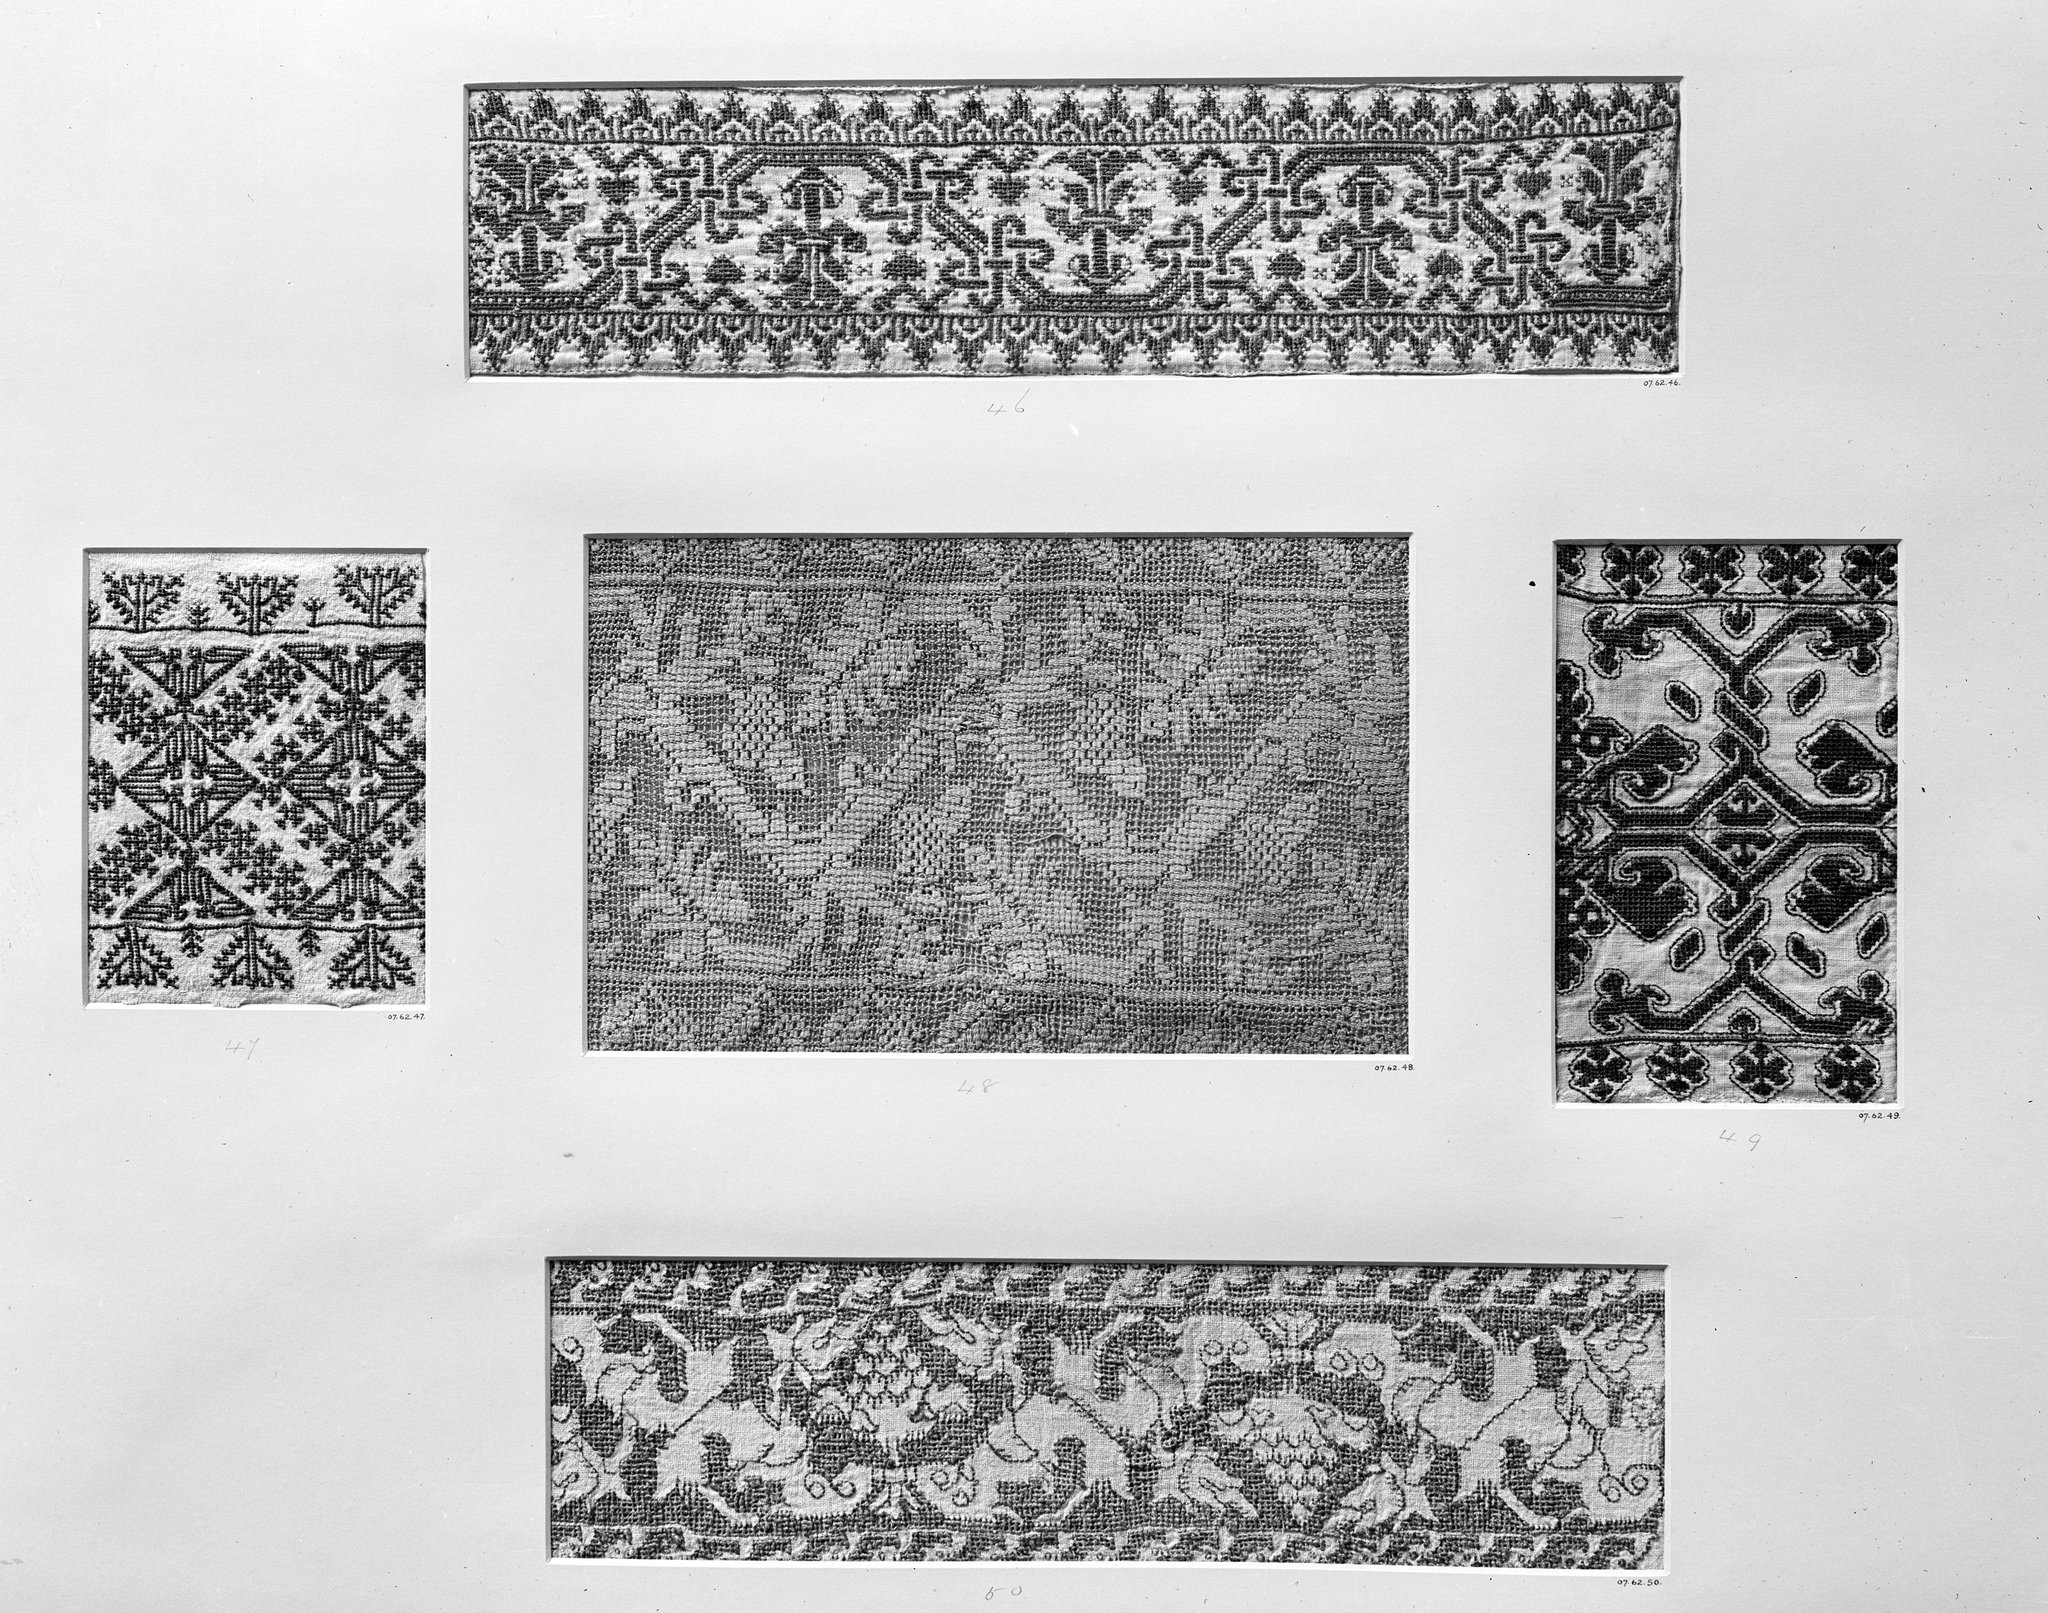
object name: border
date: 1501-1700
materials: linen, silk